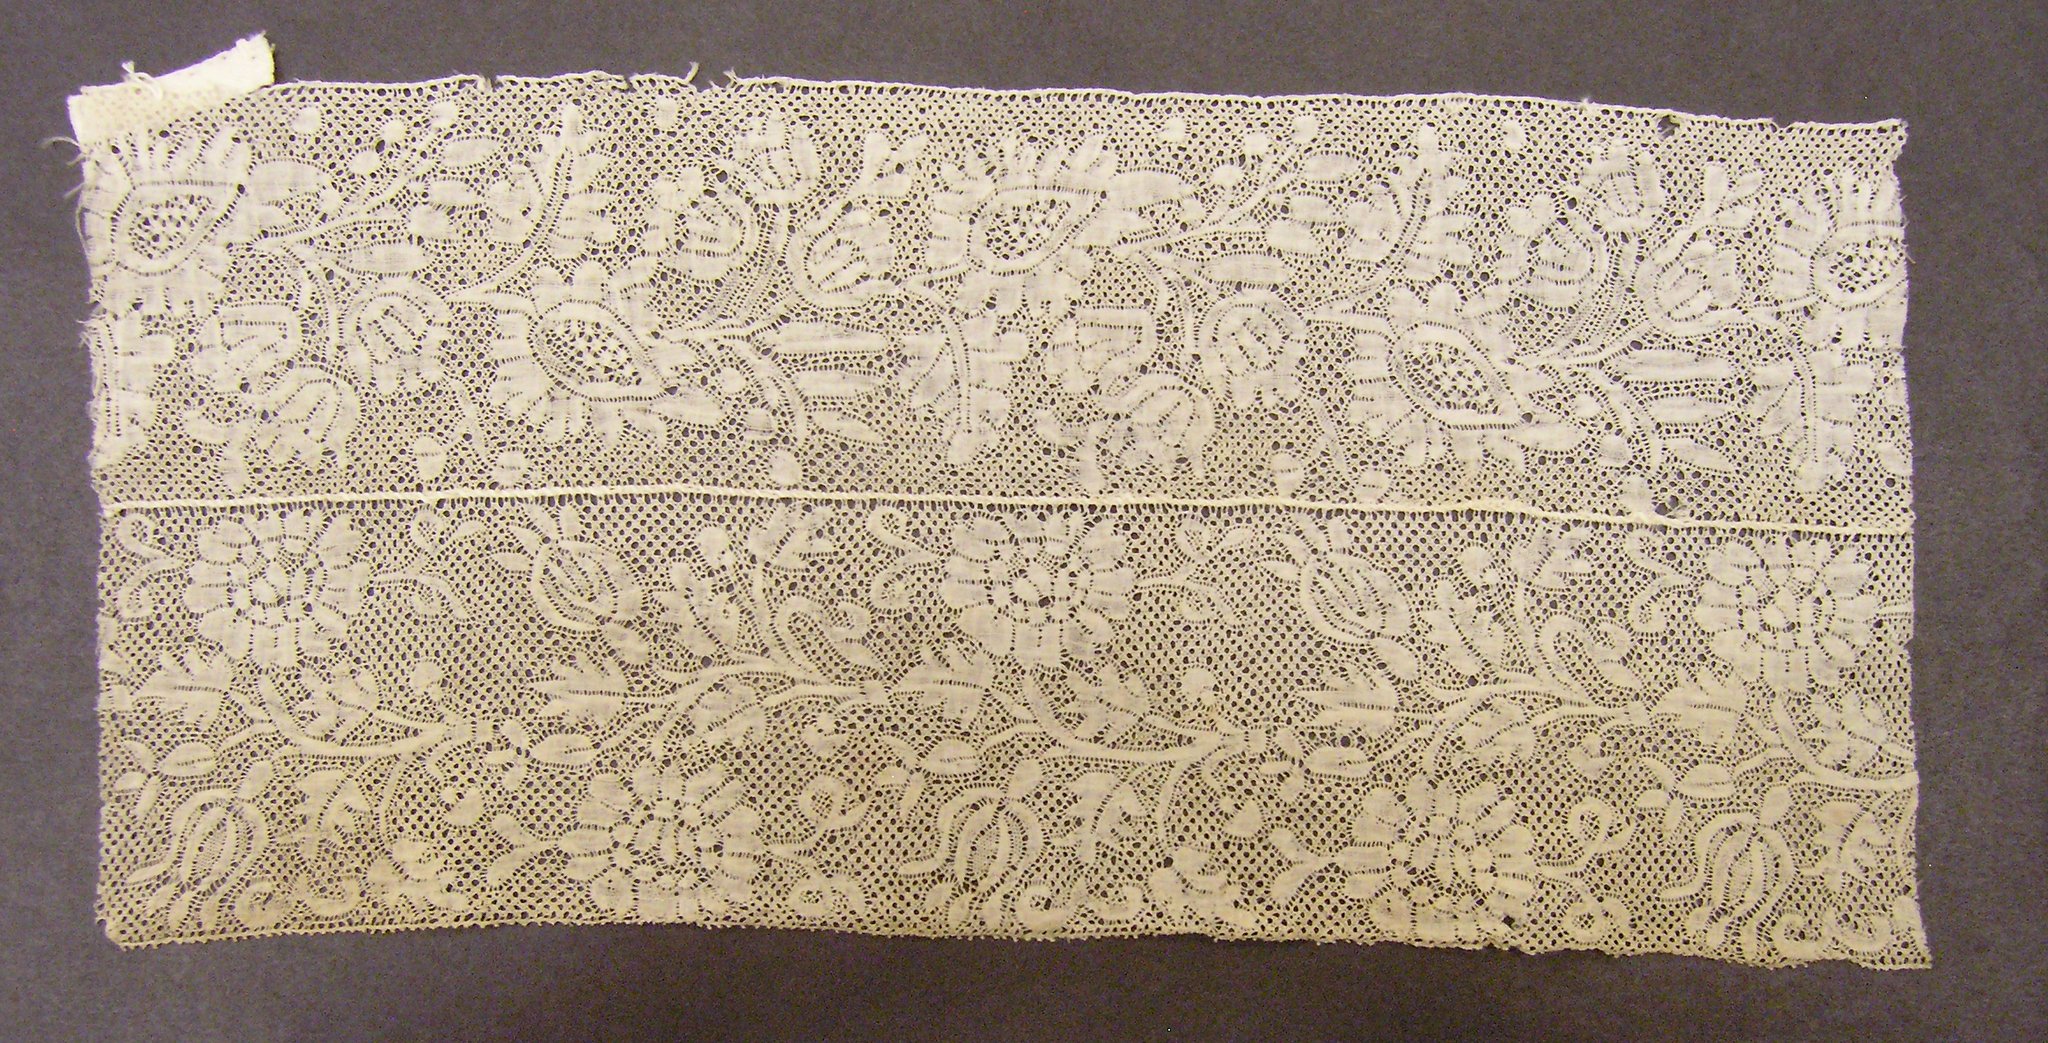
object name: piece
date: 1701-1800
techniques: lace